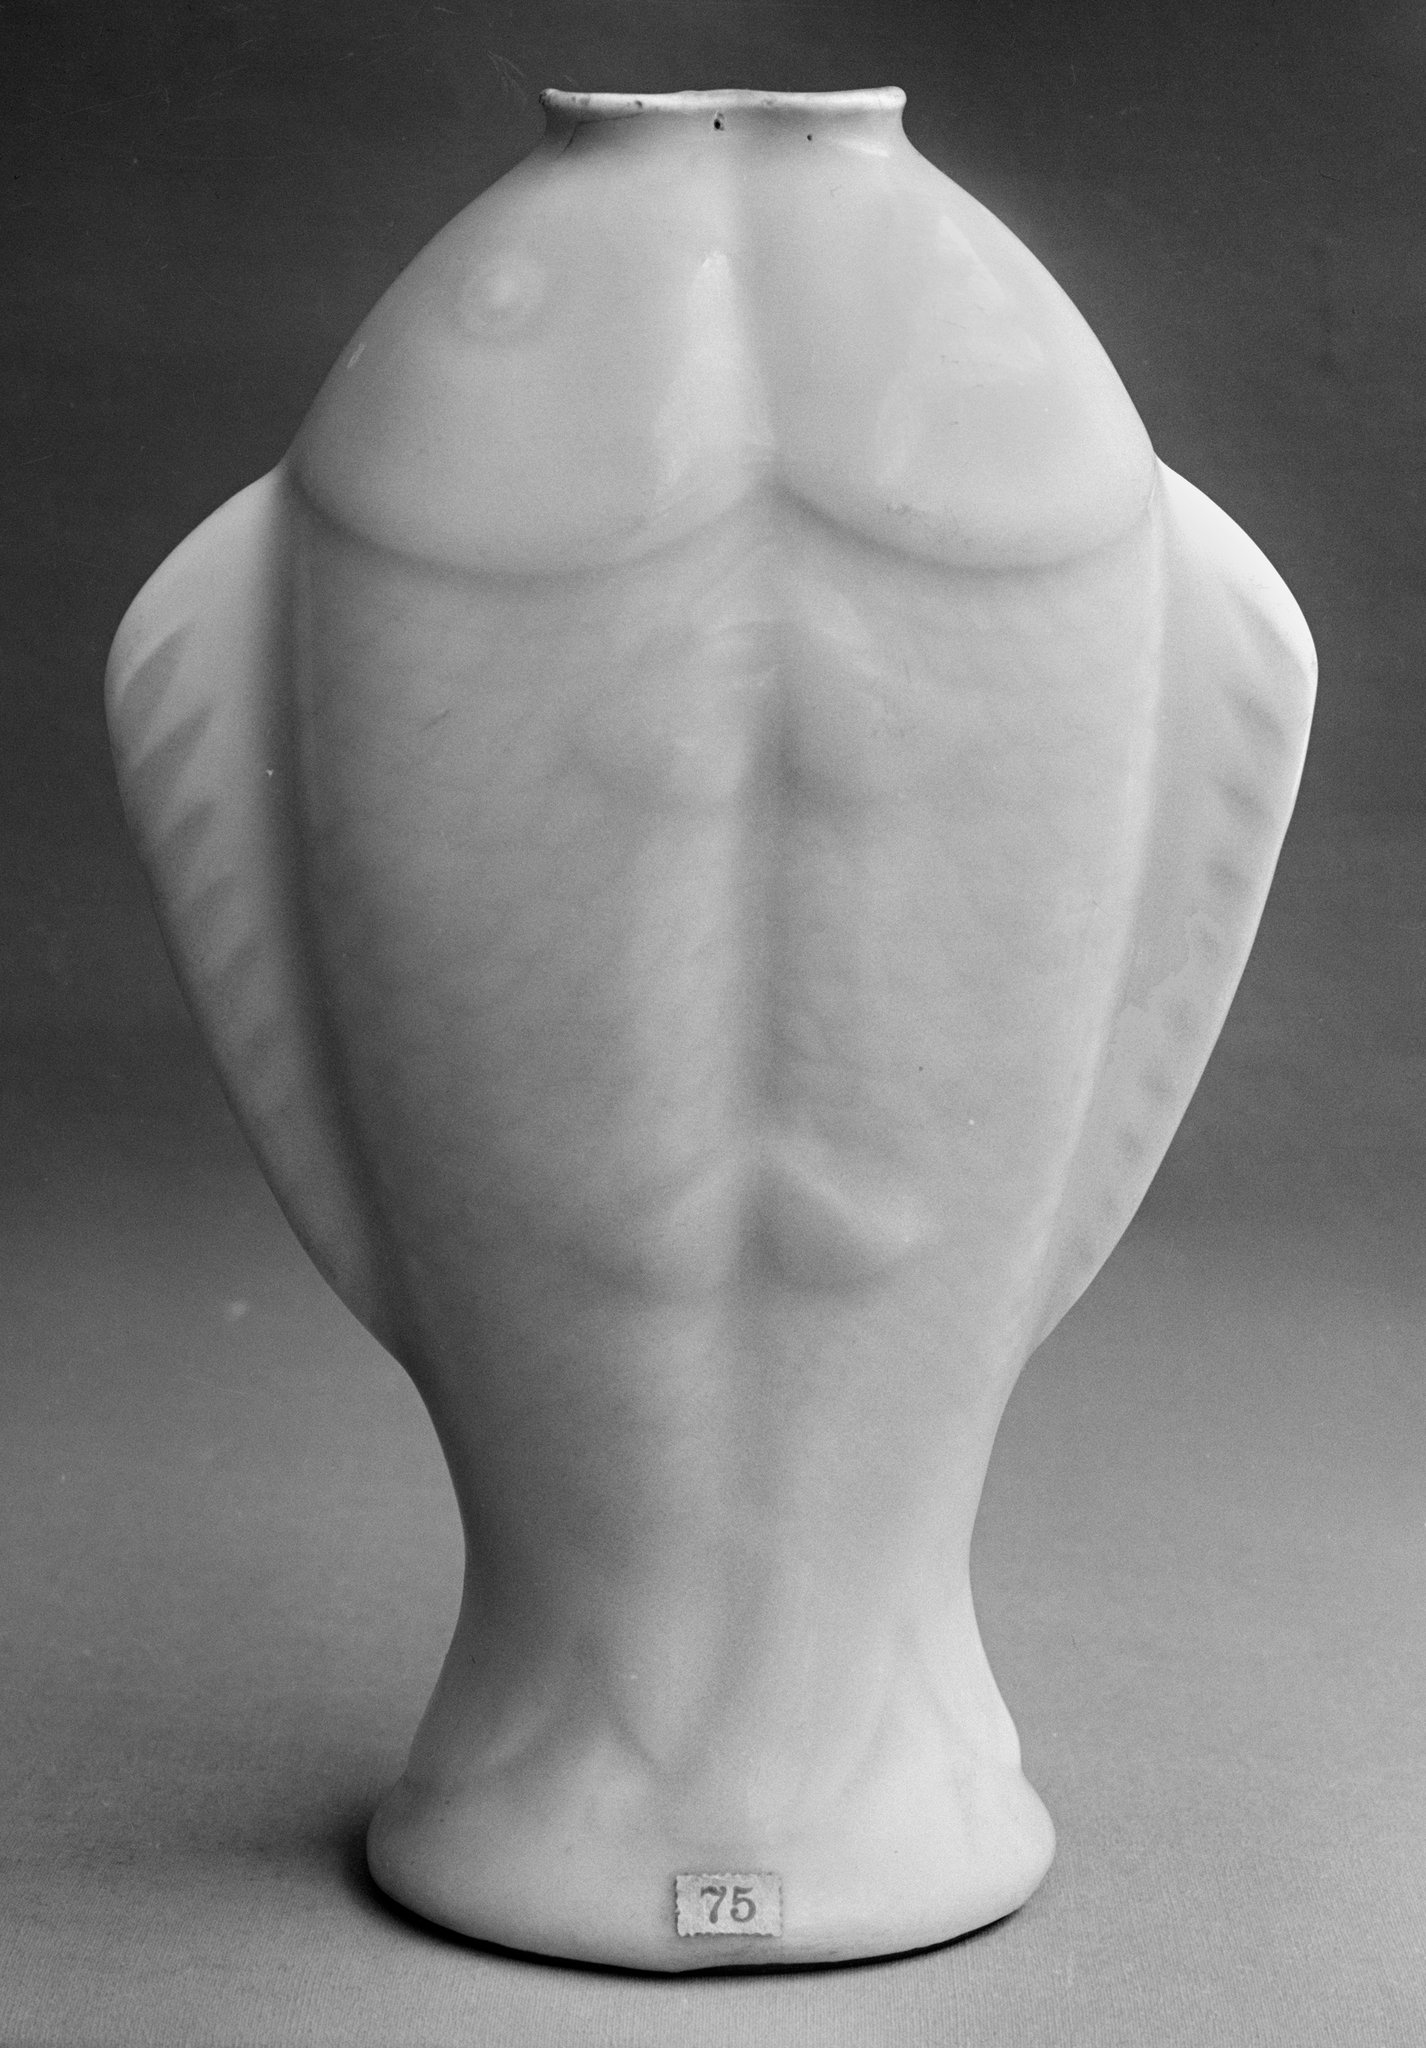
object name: vase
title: Twin-fish vase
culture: chinese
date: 1701-1800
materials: glaze, porcelain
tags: fish